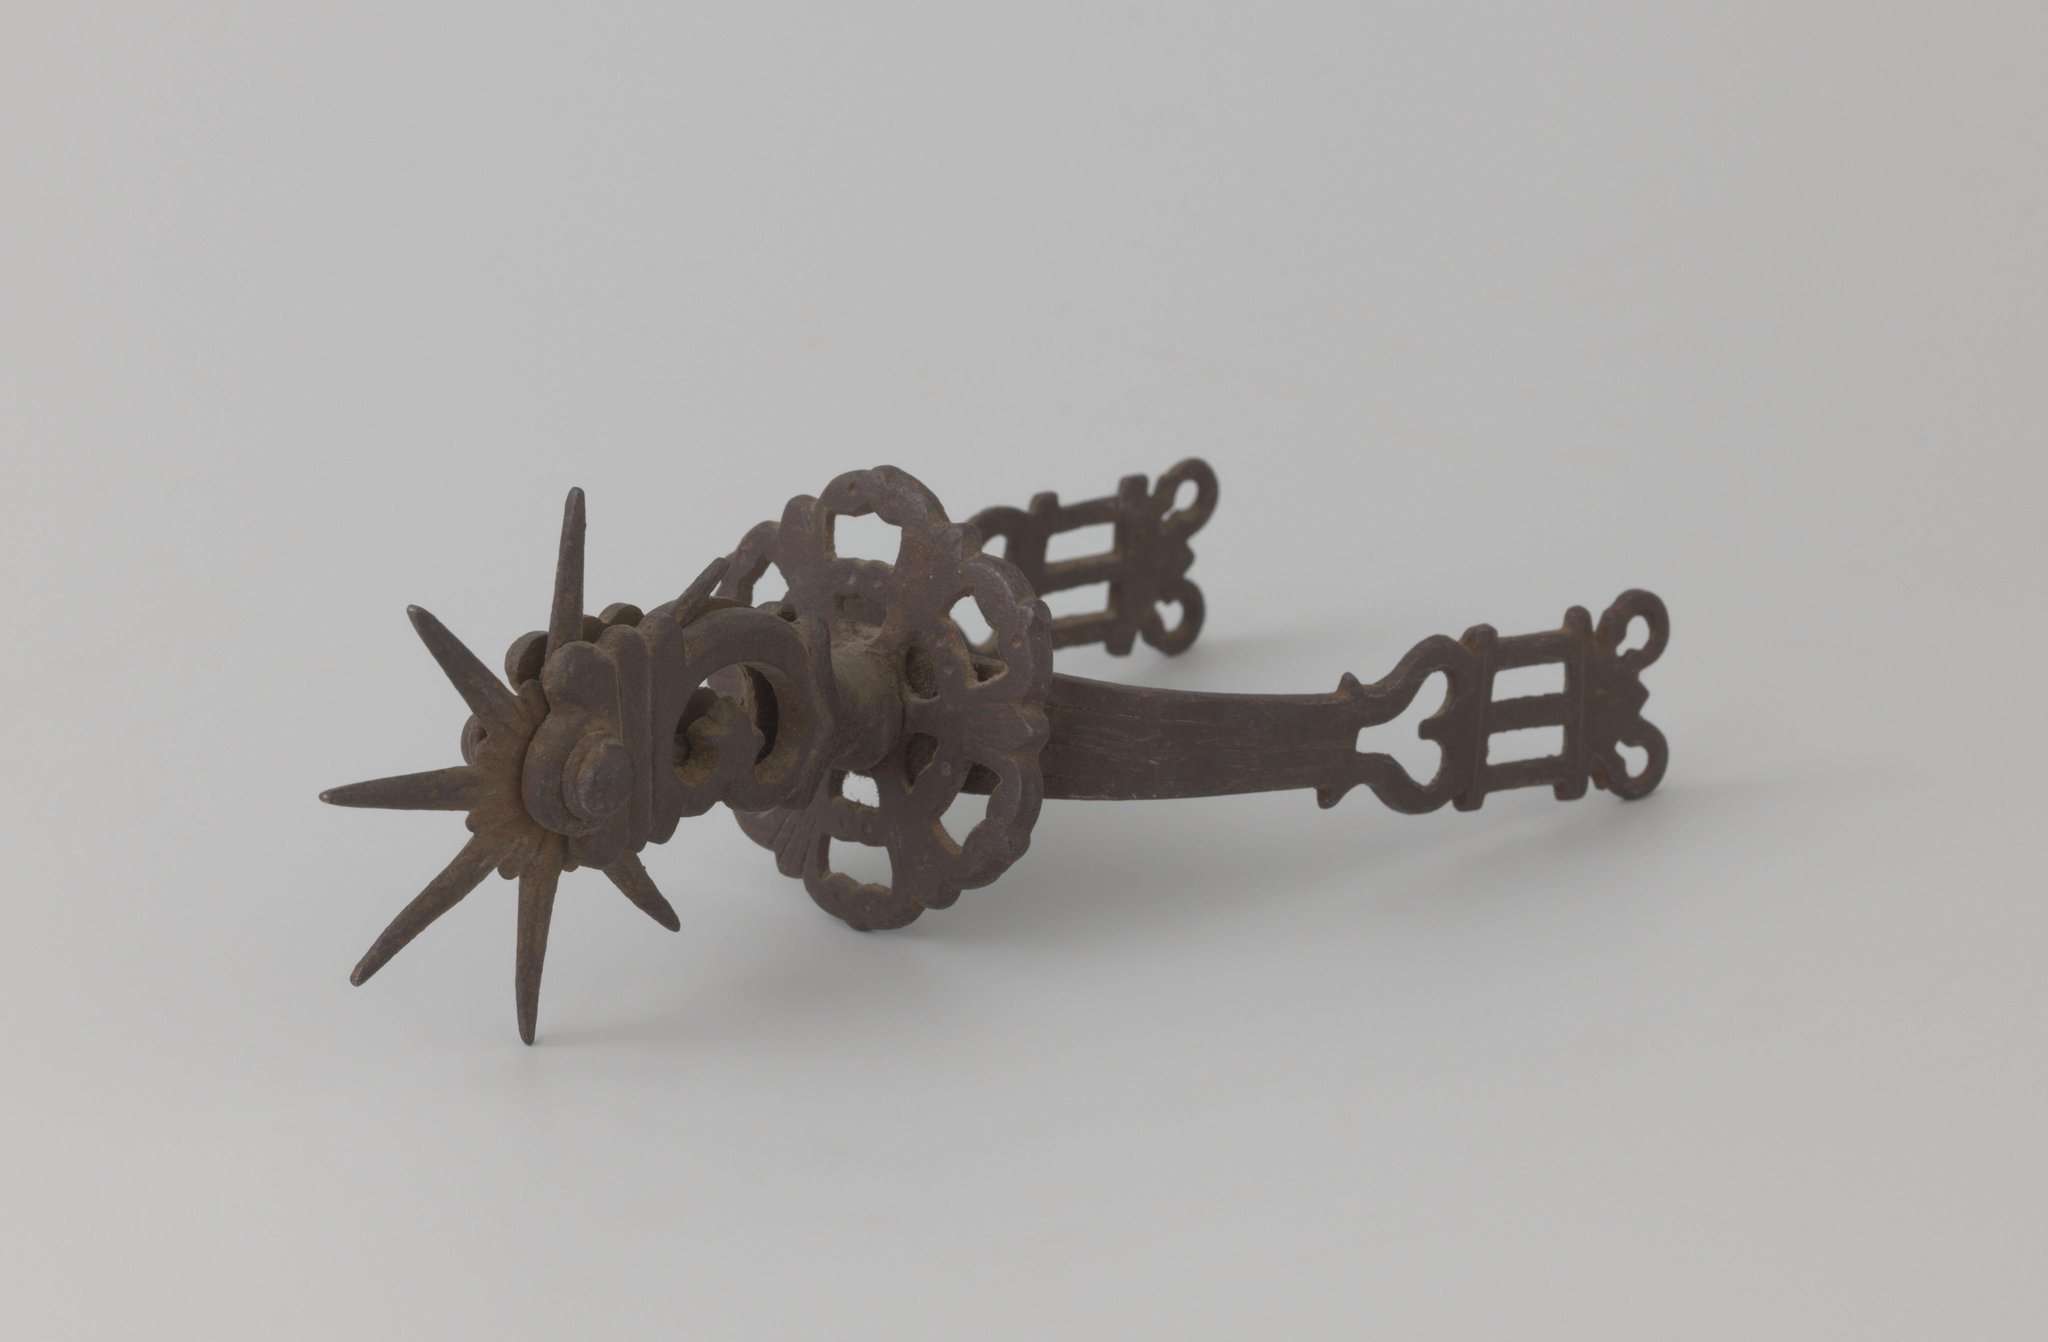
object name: ring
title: Ruiterspoor van ijzer met opengewerkte beugel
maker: Anonymous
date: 1540-1560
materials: iron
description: Ruiterspoor van ijzer met opengewerkte beugel, dito plaat en groot rad (of ring) in de vorm van een achtpuntige ster.